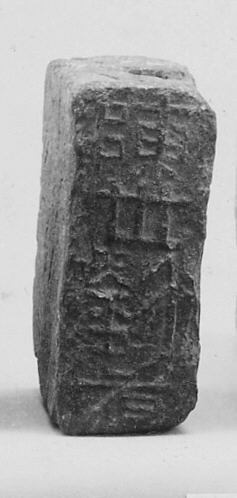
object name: tile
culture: chinese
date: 221 BCE-220 CE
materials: earthenware